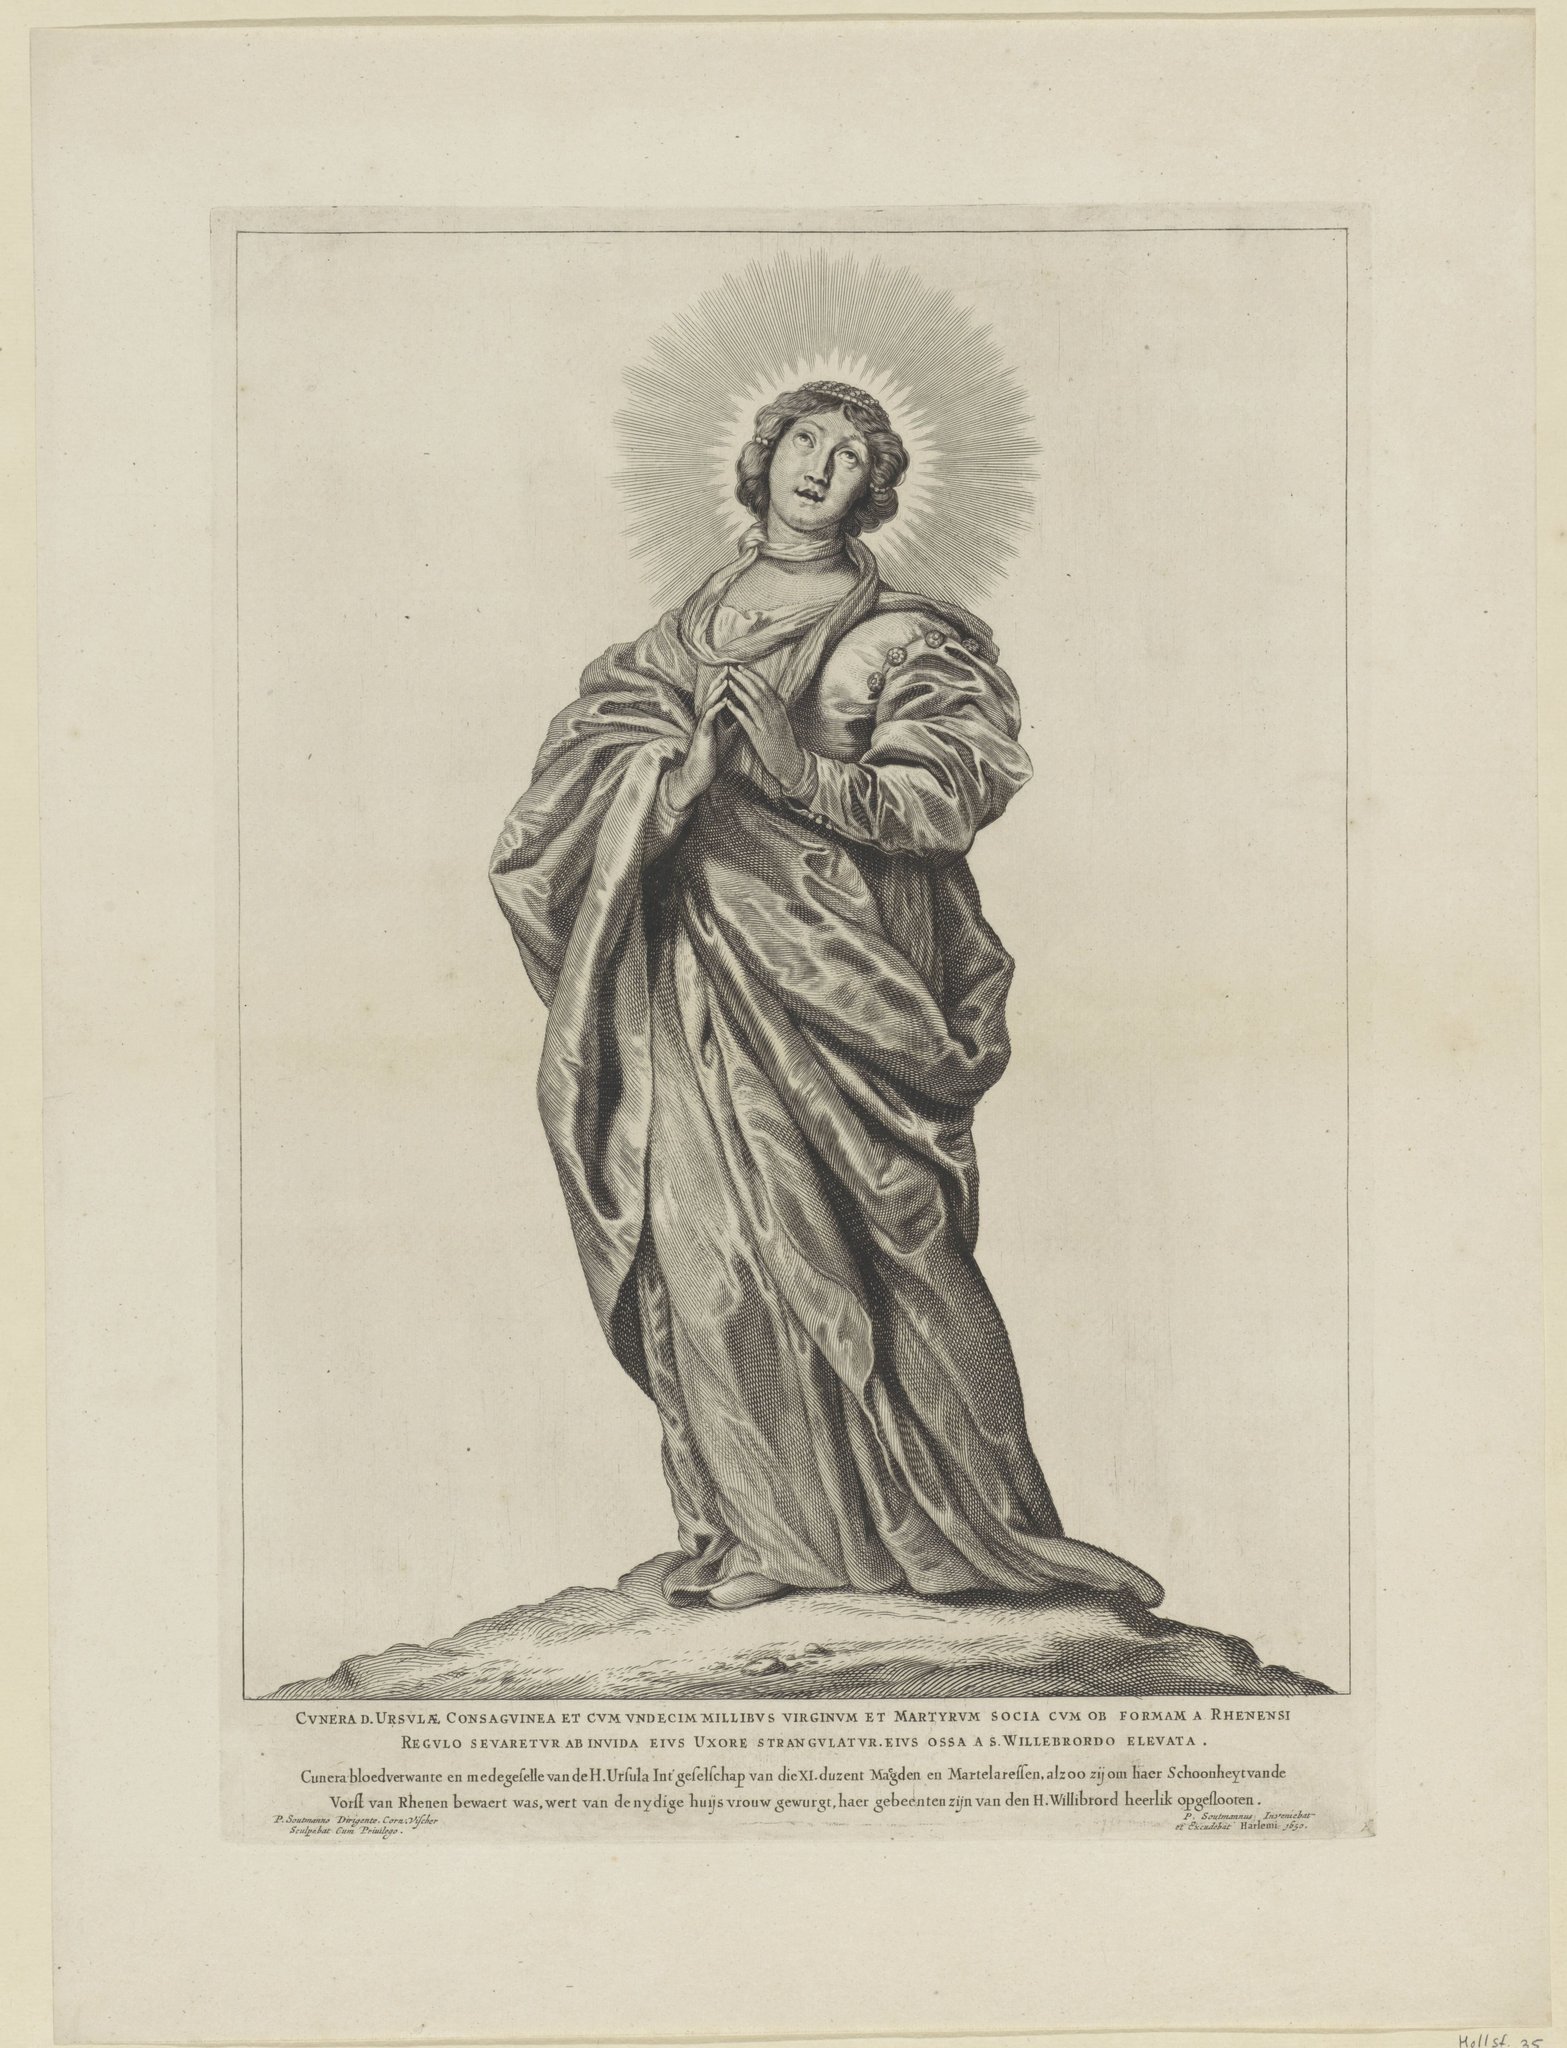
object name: print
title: Nederlandse heiligen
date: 1650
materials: paper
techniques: engraving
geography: haarlem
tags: schotland, heilige, cunera van rhenen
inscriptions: collector's mark: Lugt 240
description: Deze prent maakt deel uit van de serie: Iesv Christo, Fideli Militantis Ecclesiae Imperatori, Liberali Eivsdem, Trivmphantis, Remvneratori, hos In Foederato Belgio Militiae Svae Legatos, Sanctissimos Sacri Belli Dvces, Patriae Apostolos, Et Decora Lvmina, Cvm Dvabvs Heroinis, Militans In Iisdem Provinciis Ecclesia. Haarlem: Pieter Claesz. Soutman, 1650.